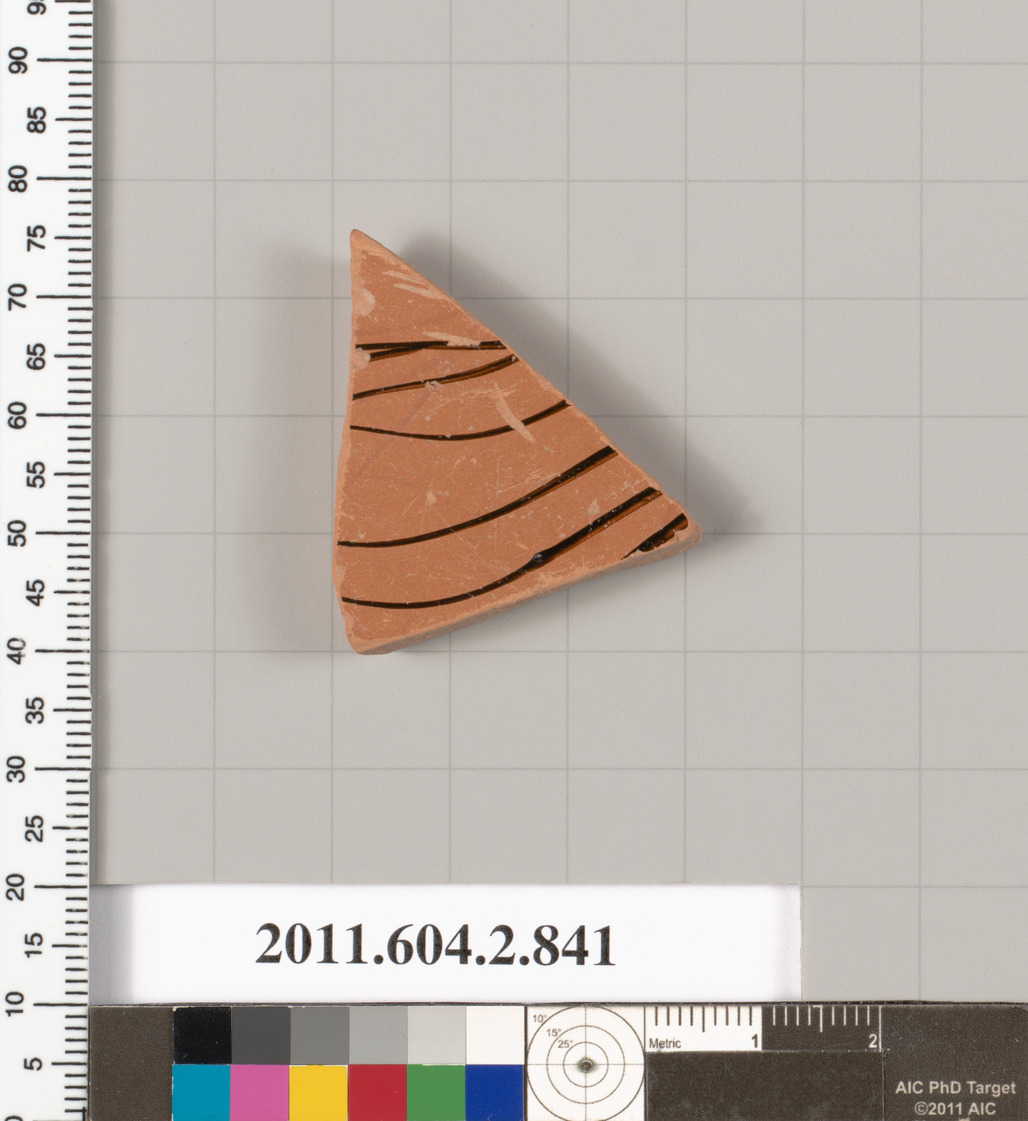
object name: bell krater fragment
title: Terracotta fragment of a bell-krater (bowl for mixing wine and water)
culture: greek, attic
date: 460-450 BCE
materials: terracotta